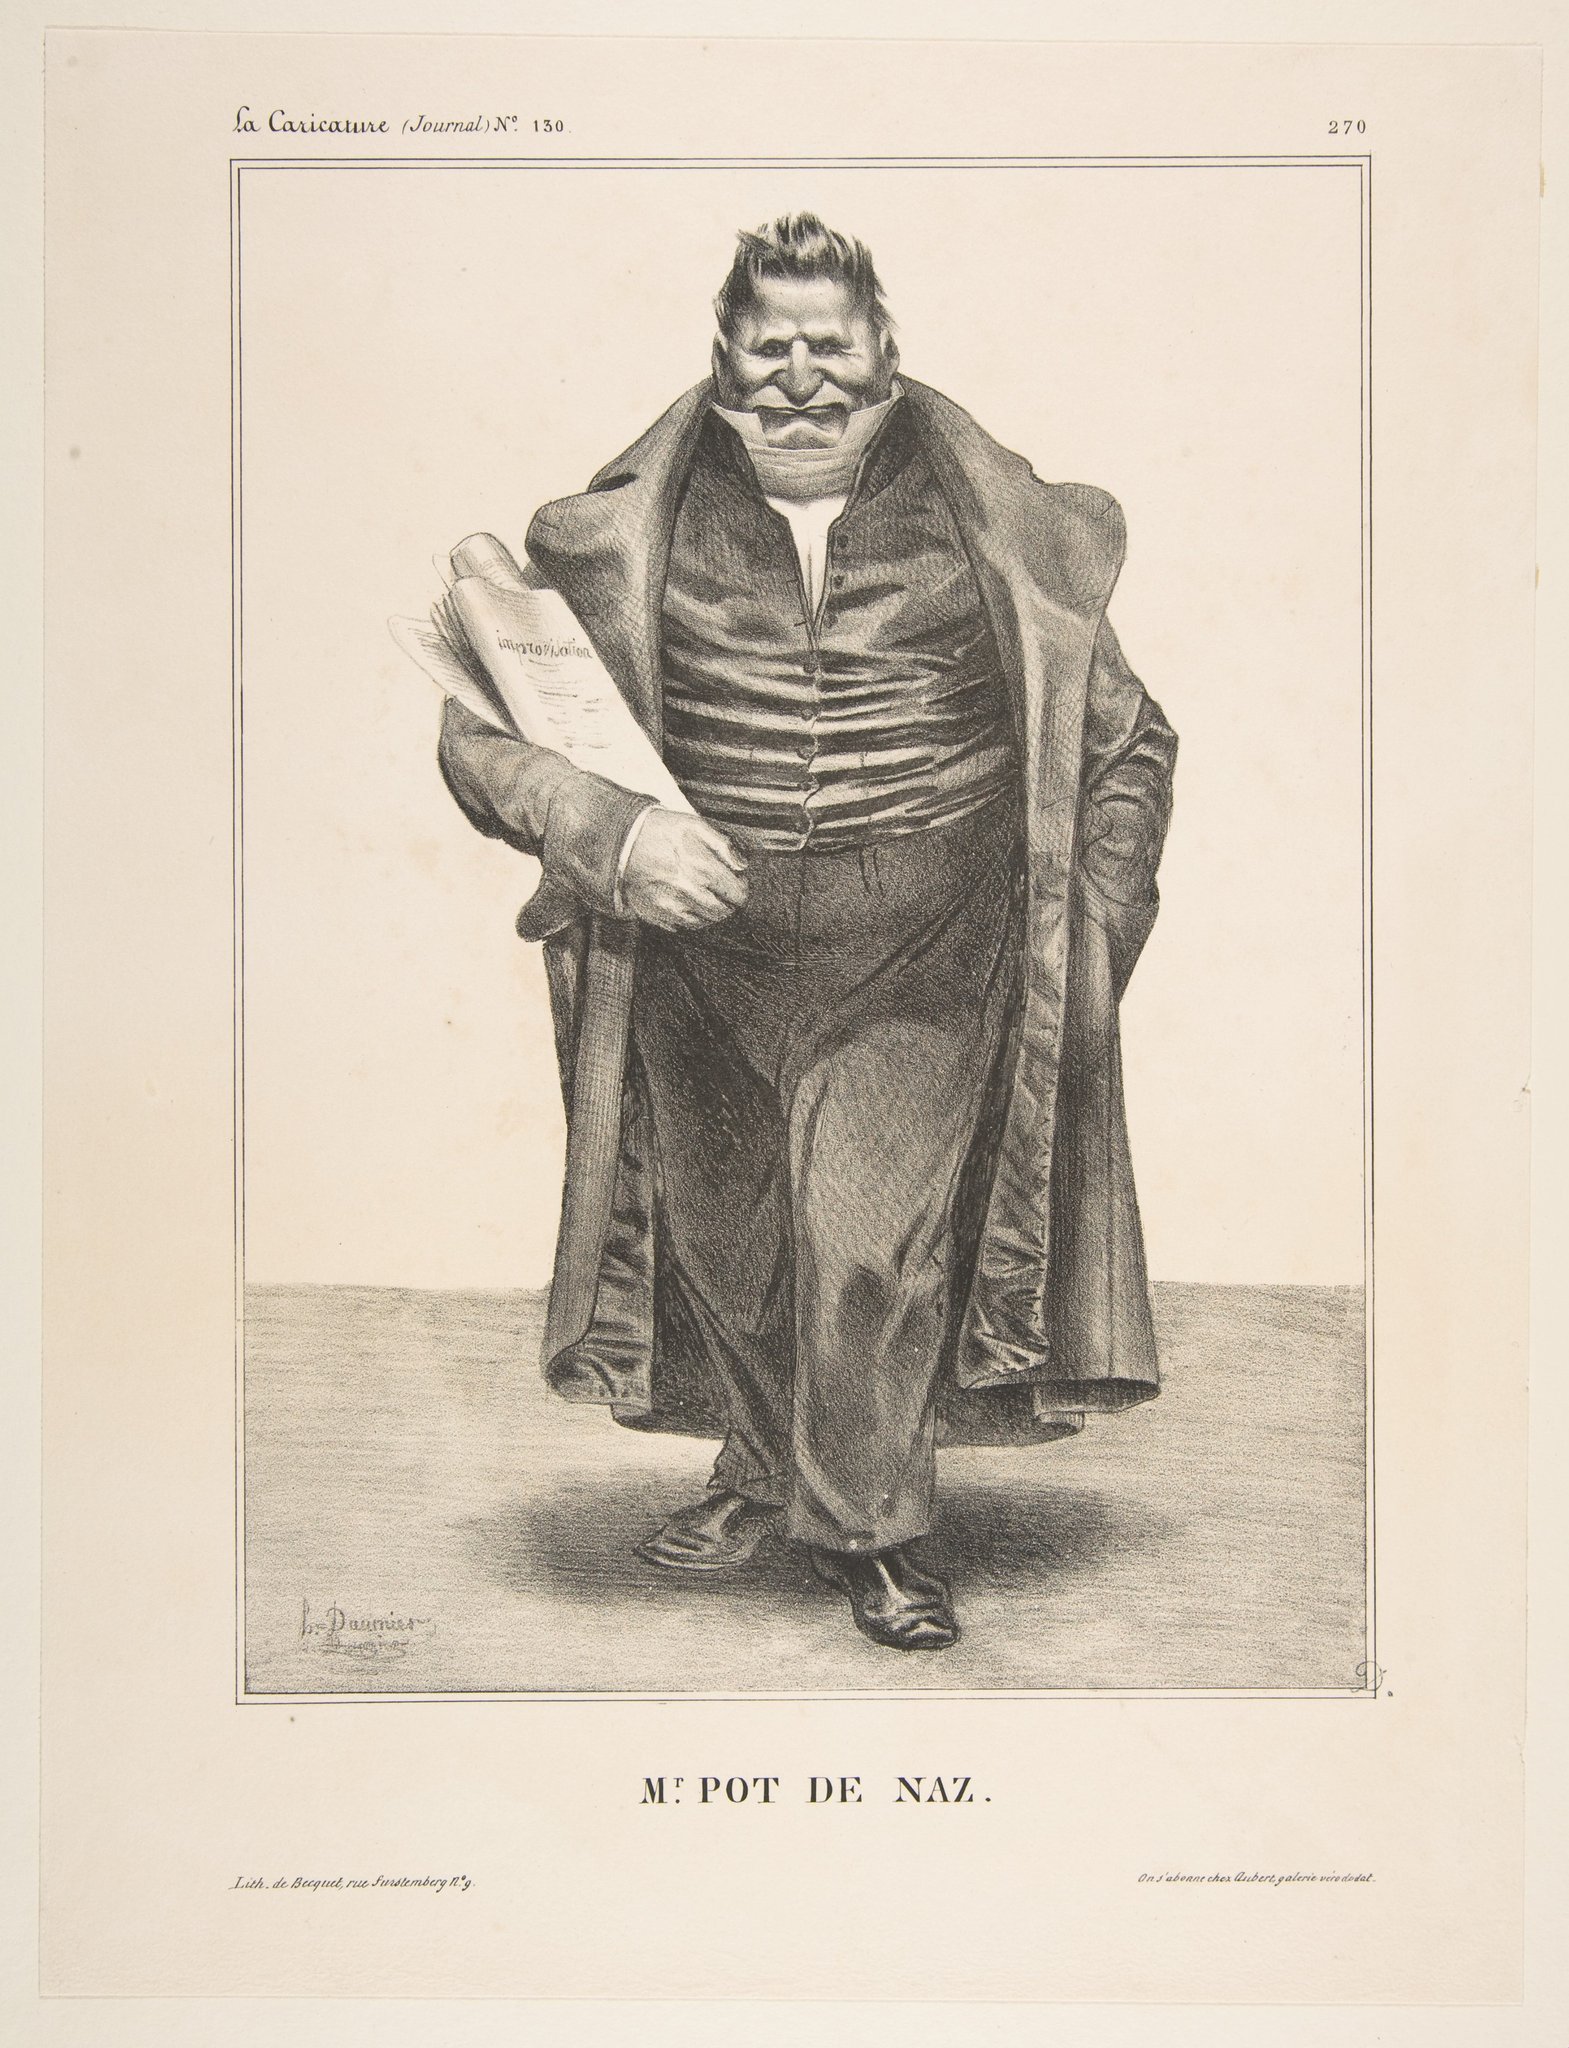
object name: print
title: De Podenas, published in "La Caricature"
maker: honoré daumier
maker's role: artist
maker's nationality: french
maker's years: 1808-1879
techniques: lithograph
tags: men,caricature